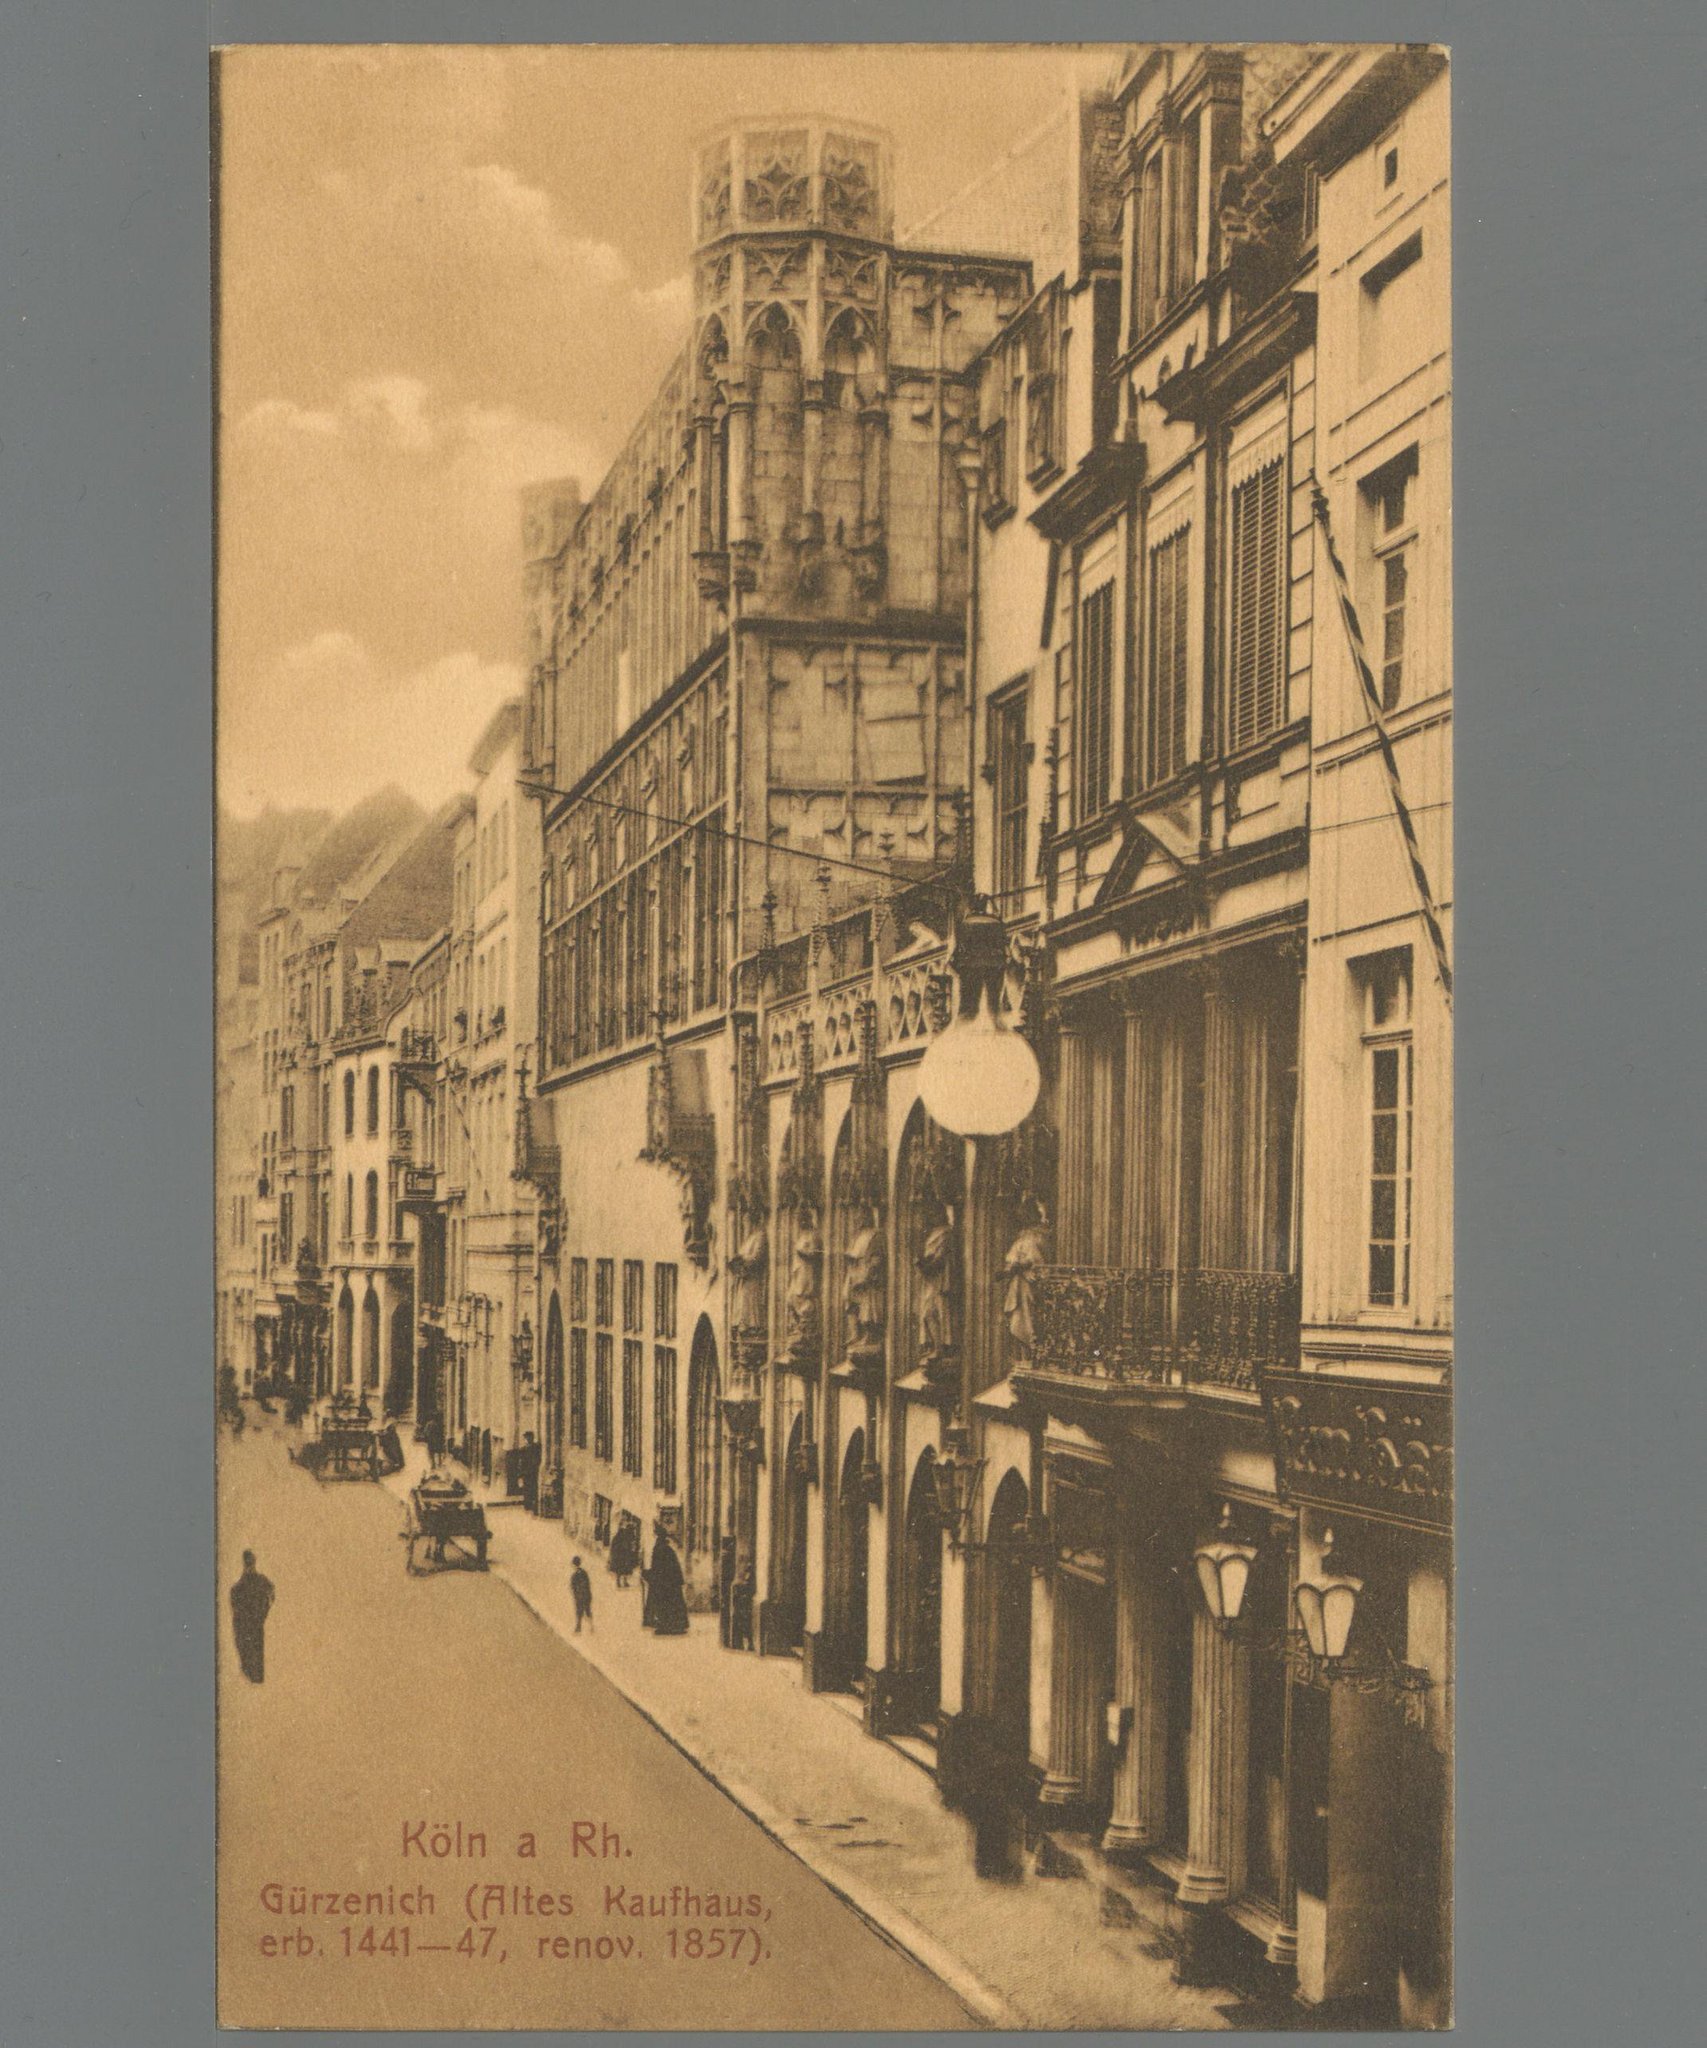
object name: photomechanical print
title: Köln a. Rh. Gürzenich (Altes Kaufhaus, erb. 1441-47, renov. 1857)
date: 1905-1920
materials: cardboard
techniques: photograph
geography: cologne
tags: street, cologne